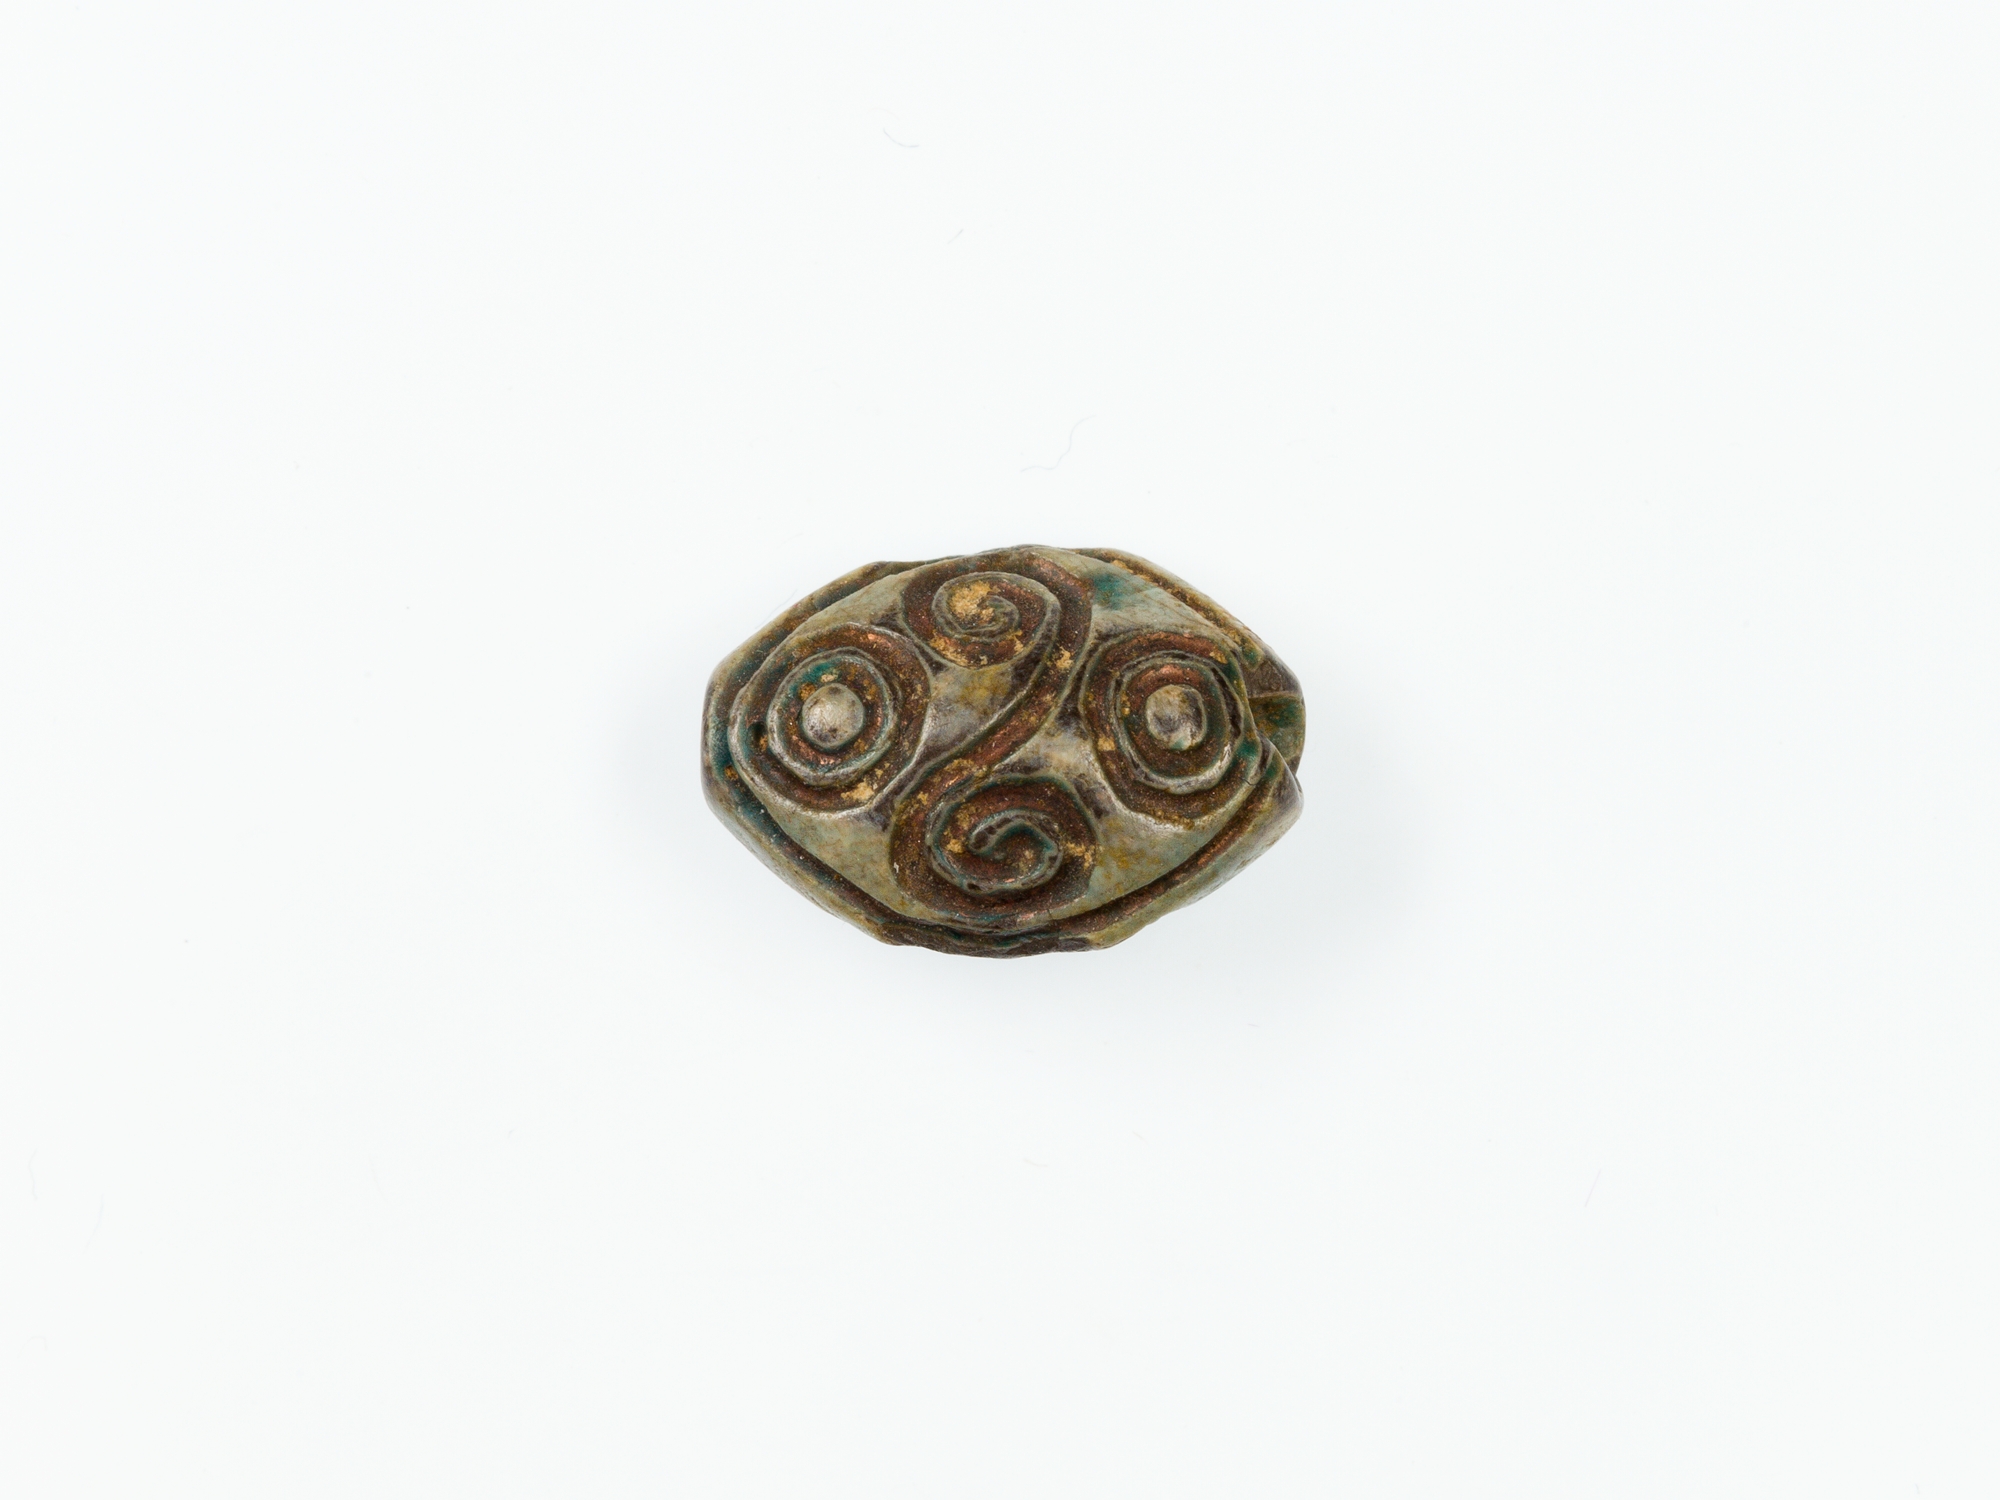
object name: bead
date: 1981-1295 BCE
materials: stone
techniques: glazing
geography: egypt